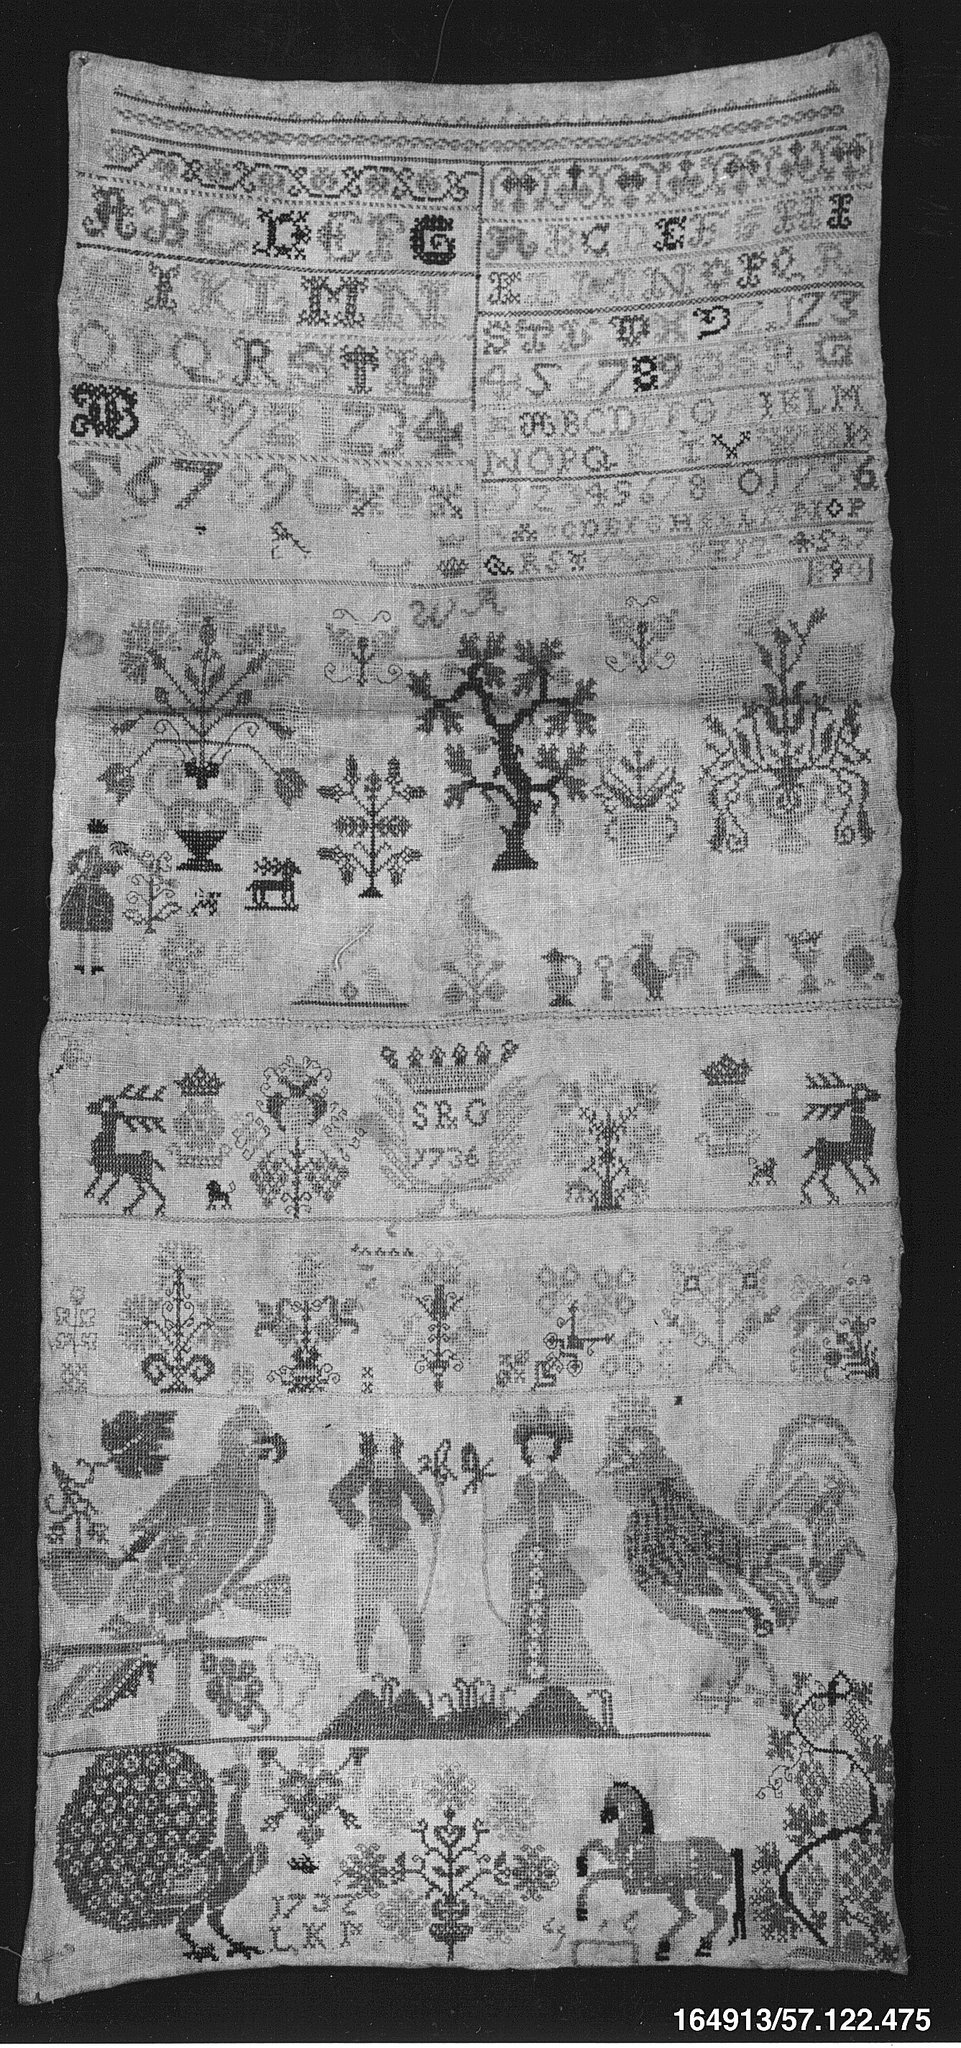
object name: sampler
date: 1732-1736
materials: linen, silk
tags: chickens,men,women,peacocks,deer,horses